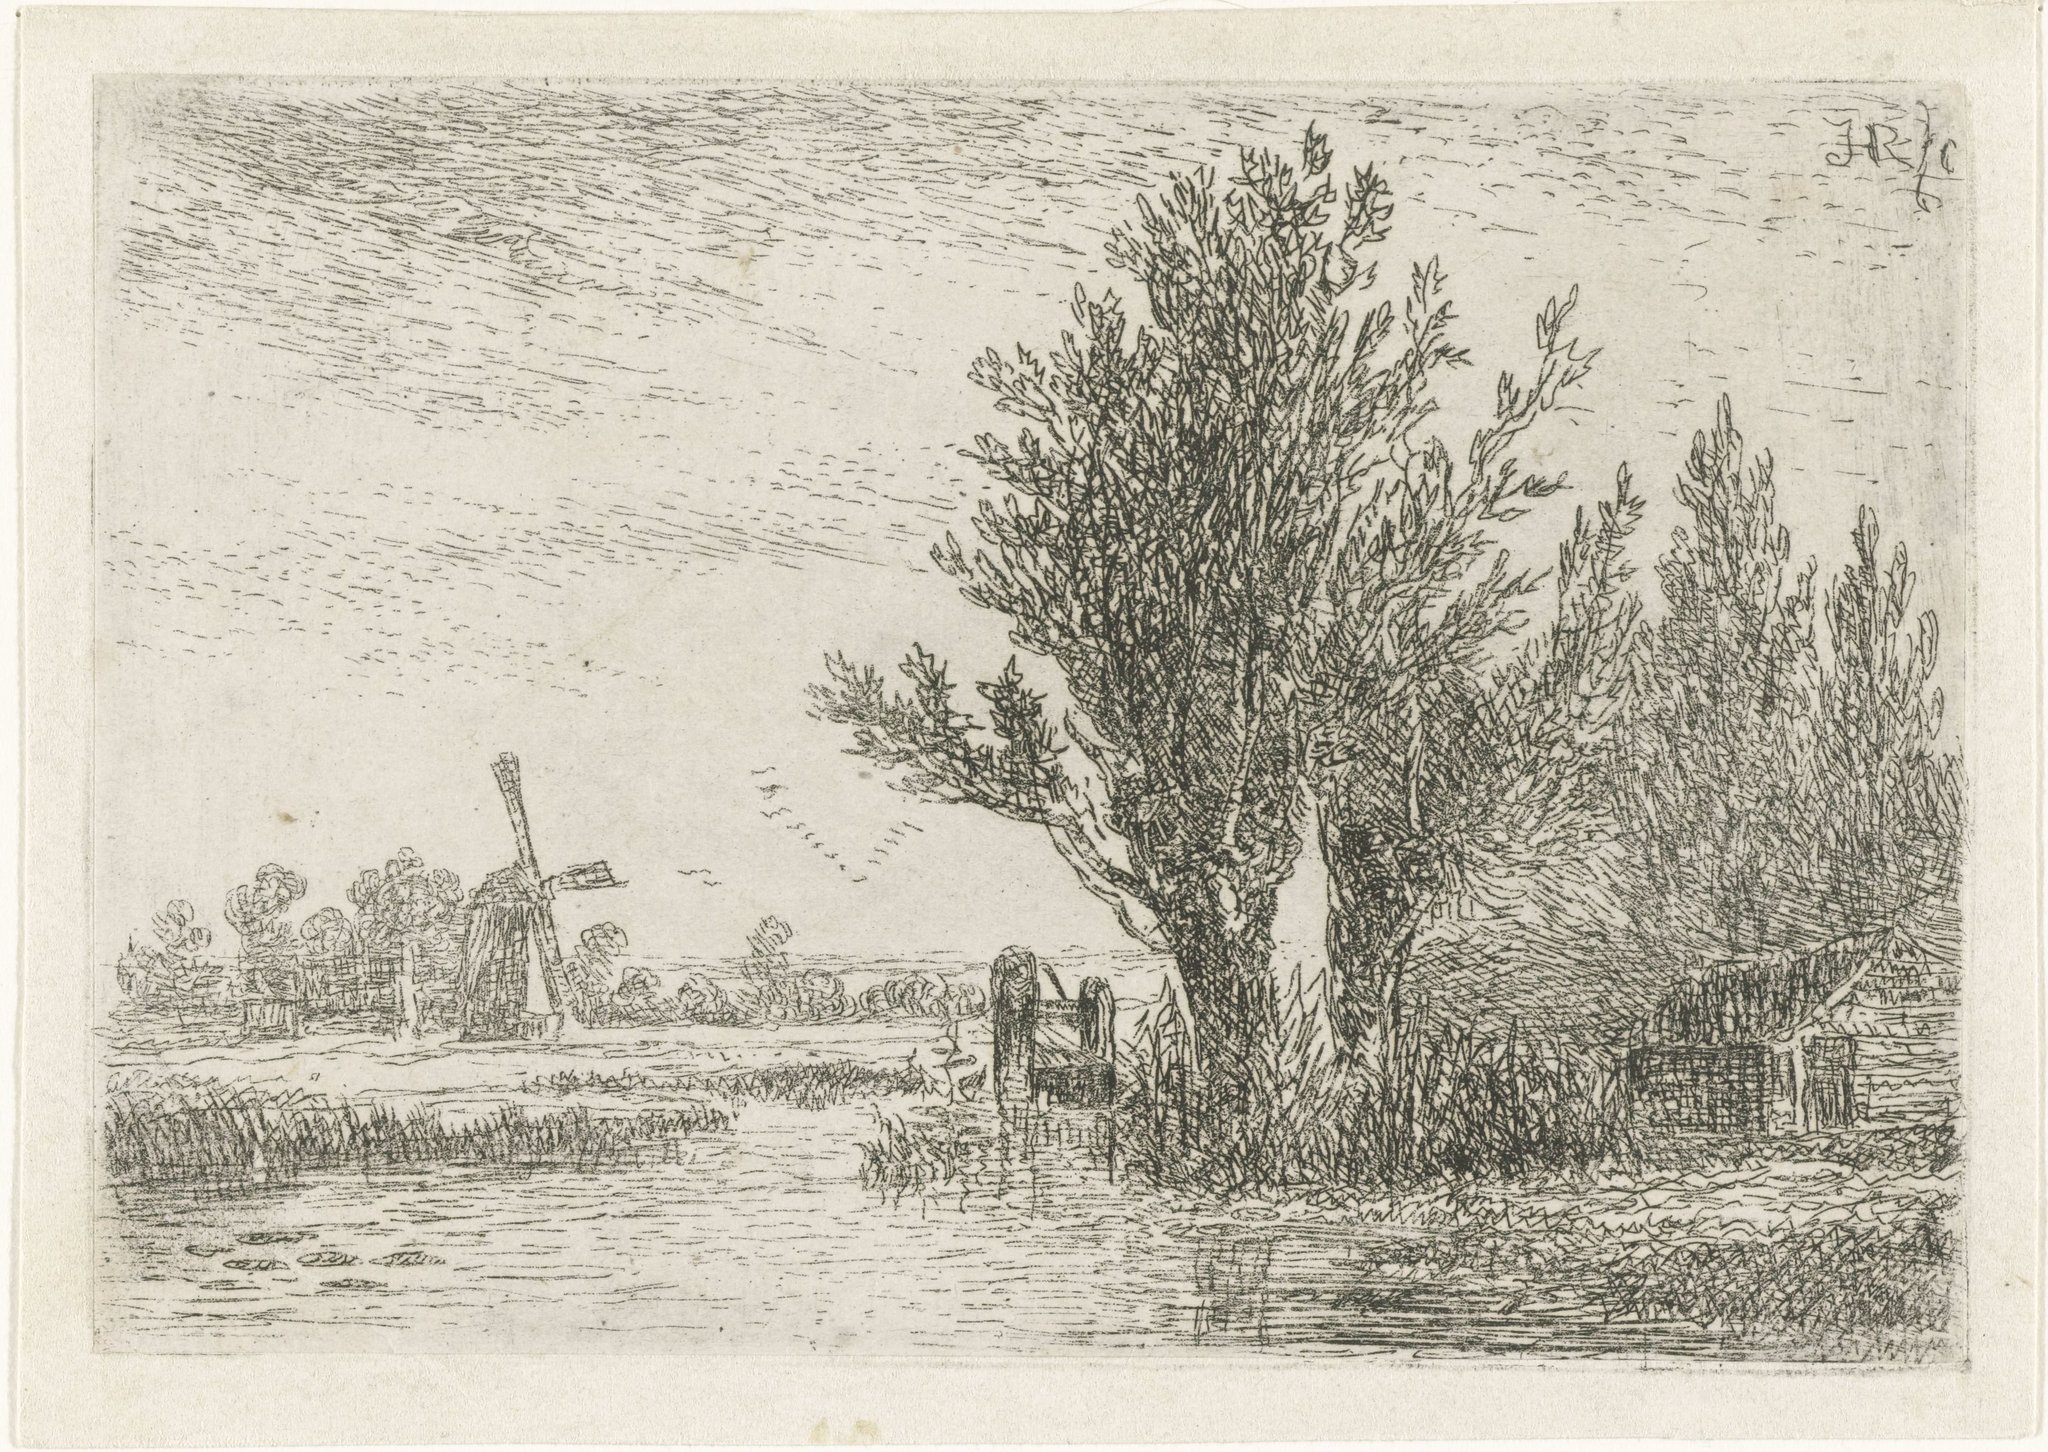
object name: print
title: Sluis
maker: hermanus jan hendrik van rijkelijkhuysen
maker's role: painter, print maker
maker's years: 1813-1883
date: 1823-1883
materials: paper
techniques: etching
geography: utrecht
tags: sluice, weir, river, trees: willow, windmill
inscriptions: collector's mark: Lugt 2228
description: Gezicht op een rivierlandschap met op de voorgrond een sluisje en twee knotwilgen. Op de achtergrond de contouren van een molen.